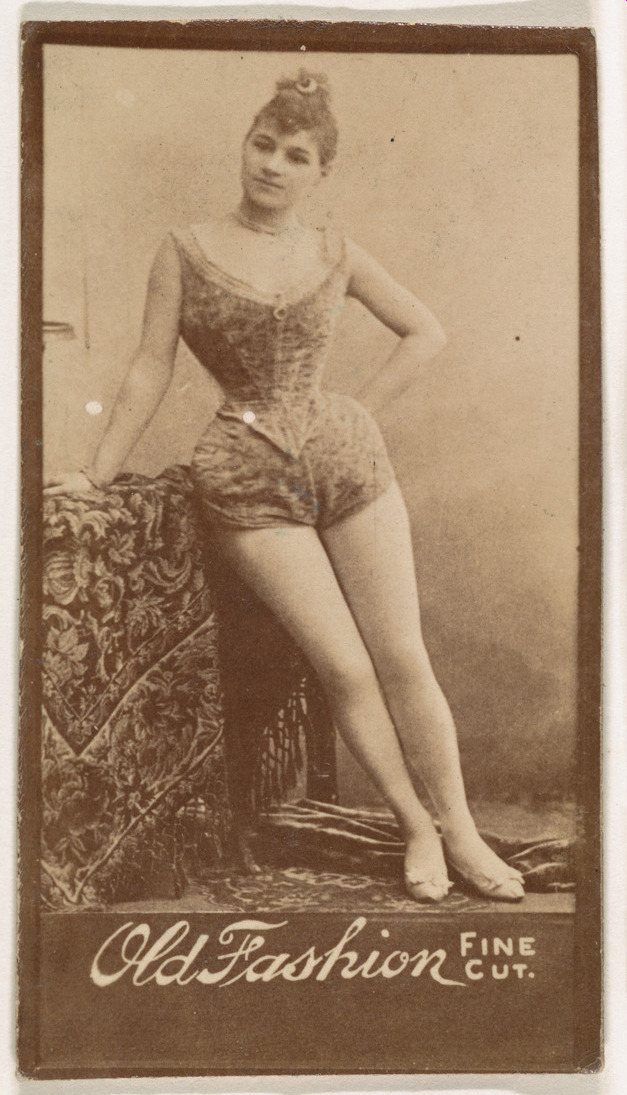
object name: photograph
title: Actress leaning against cloth-covered table, from the Actresses series (N664) promoting Old Fashion Fine Cut Tobacco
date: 1888-1890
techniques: albumen silver print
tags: portraits,women,actresses